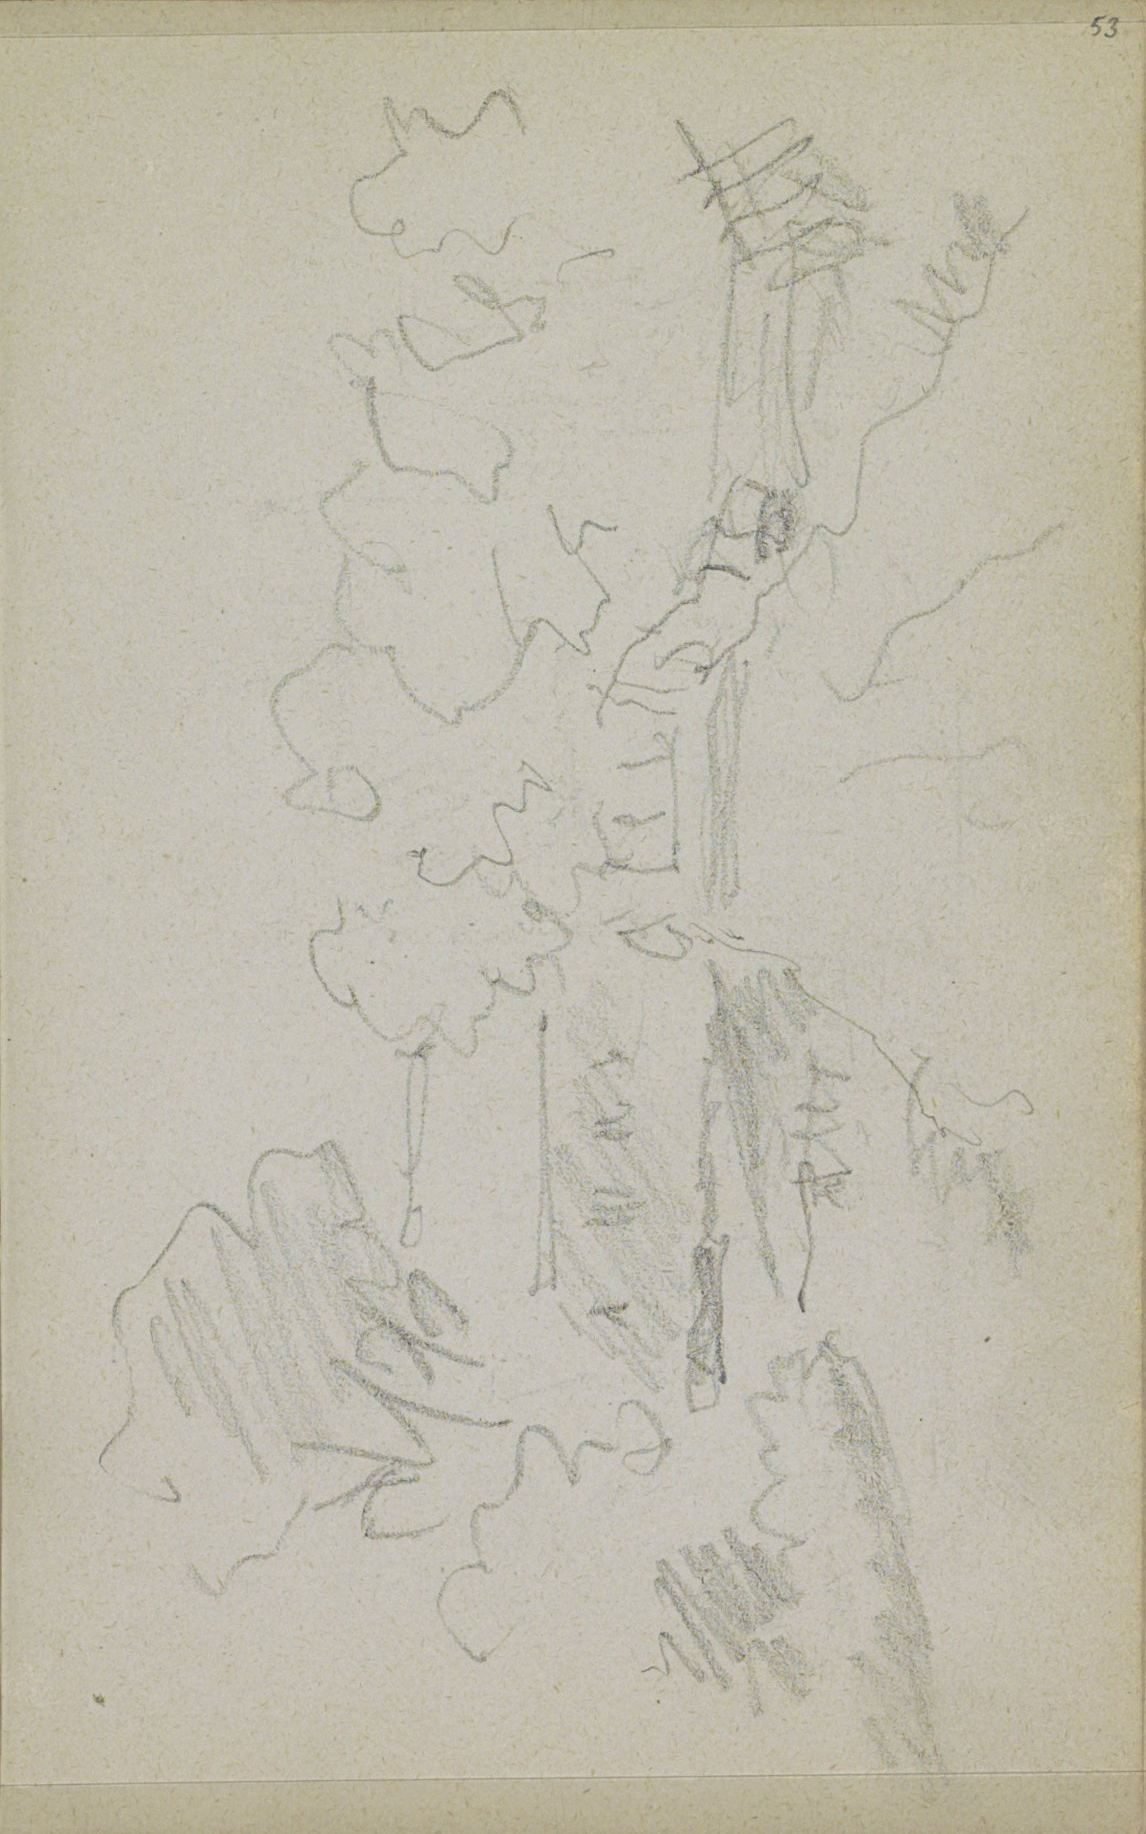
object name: sketchbook leaf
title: Gezicht op een weg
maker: adrianus eversen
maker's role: draughtsman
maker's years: 1818-1897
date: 1828-1897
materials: paper, pencil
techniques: stumping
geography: netherlands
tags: road, path, bridge, civic architecture; edifices; dwellings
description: Gezicht op een weg, mogelijk met een brug. In de verte een gebouw. Blad 53 recto uit een schetsboek met 58 bladen.